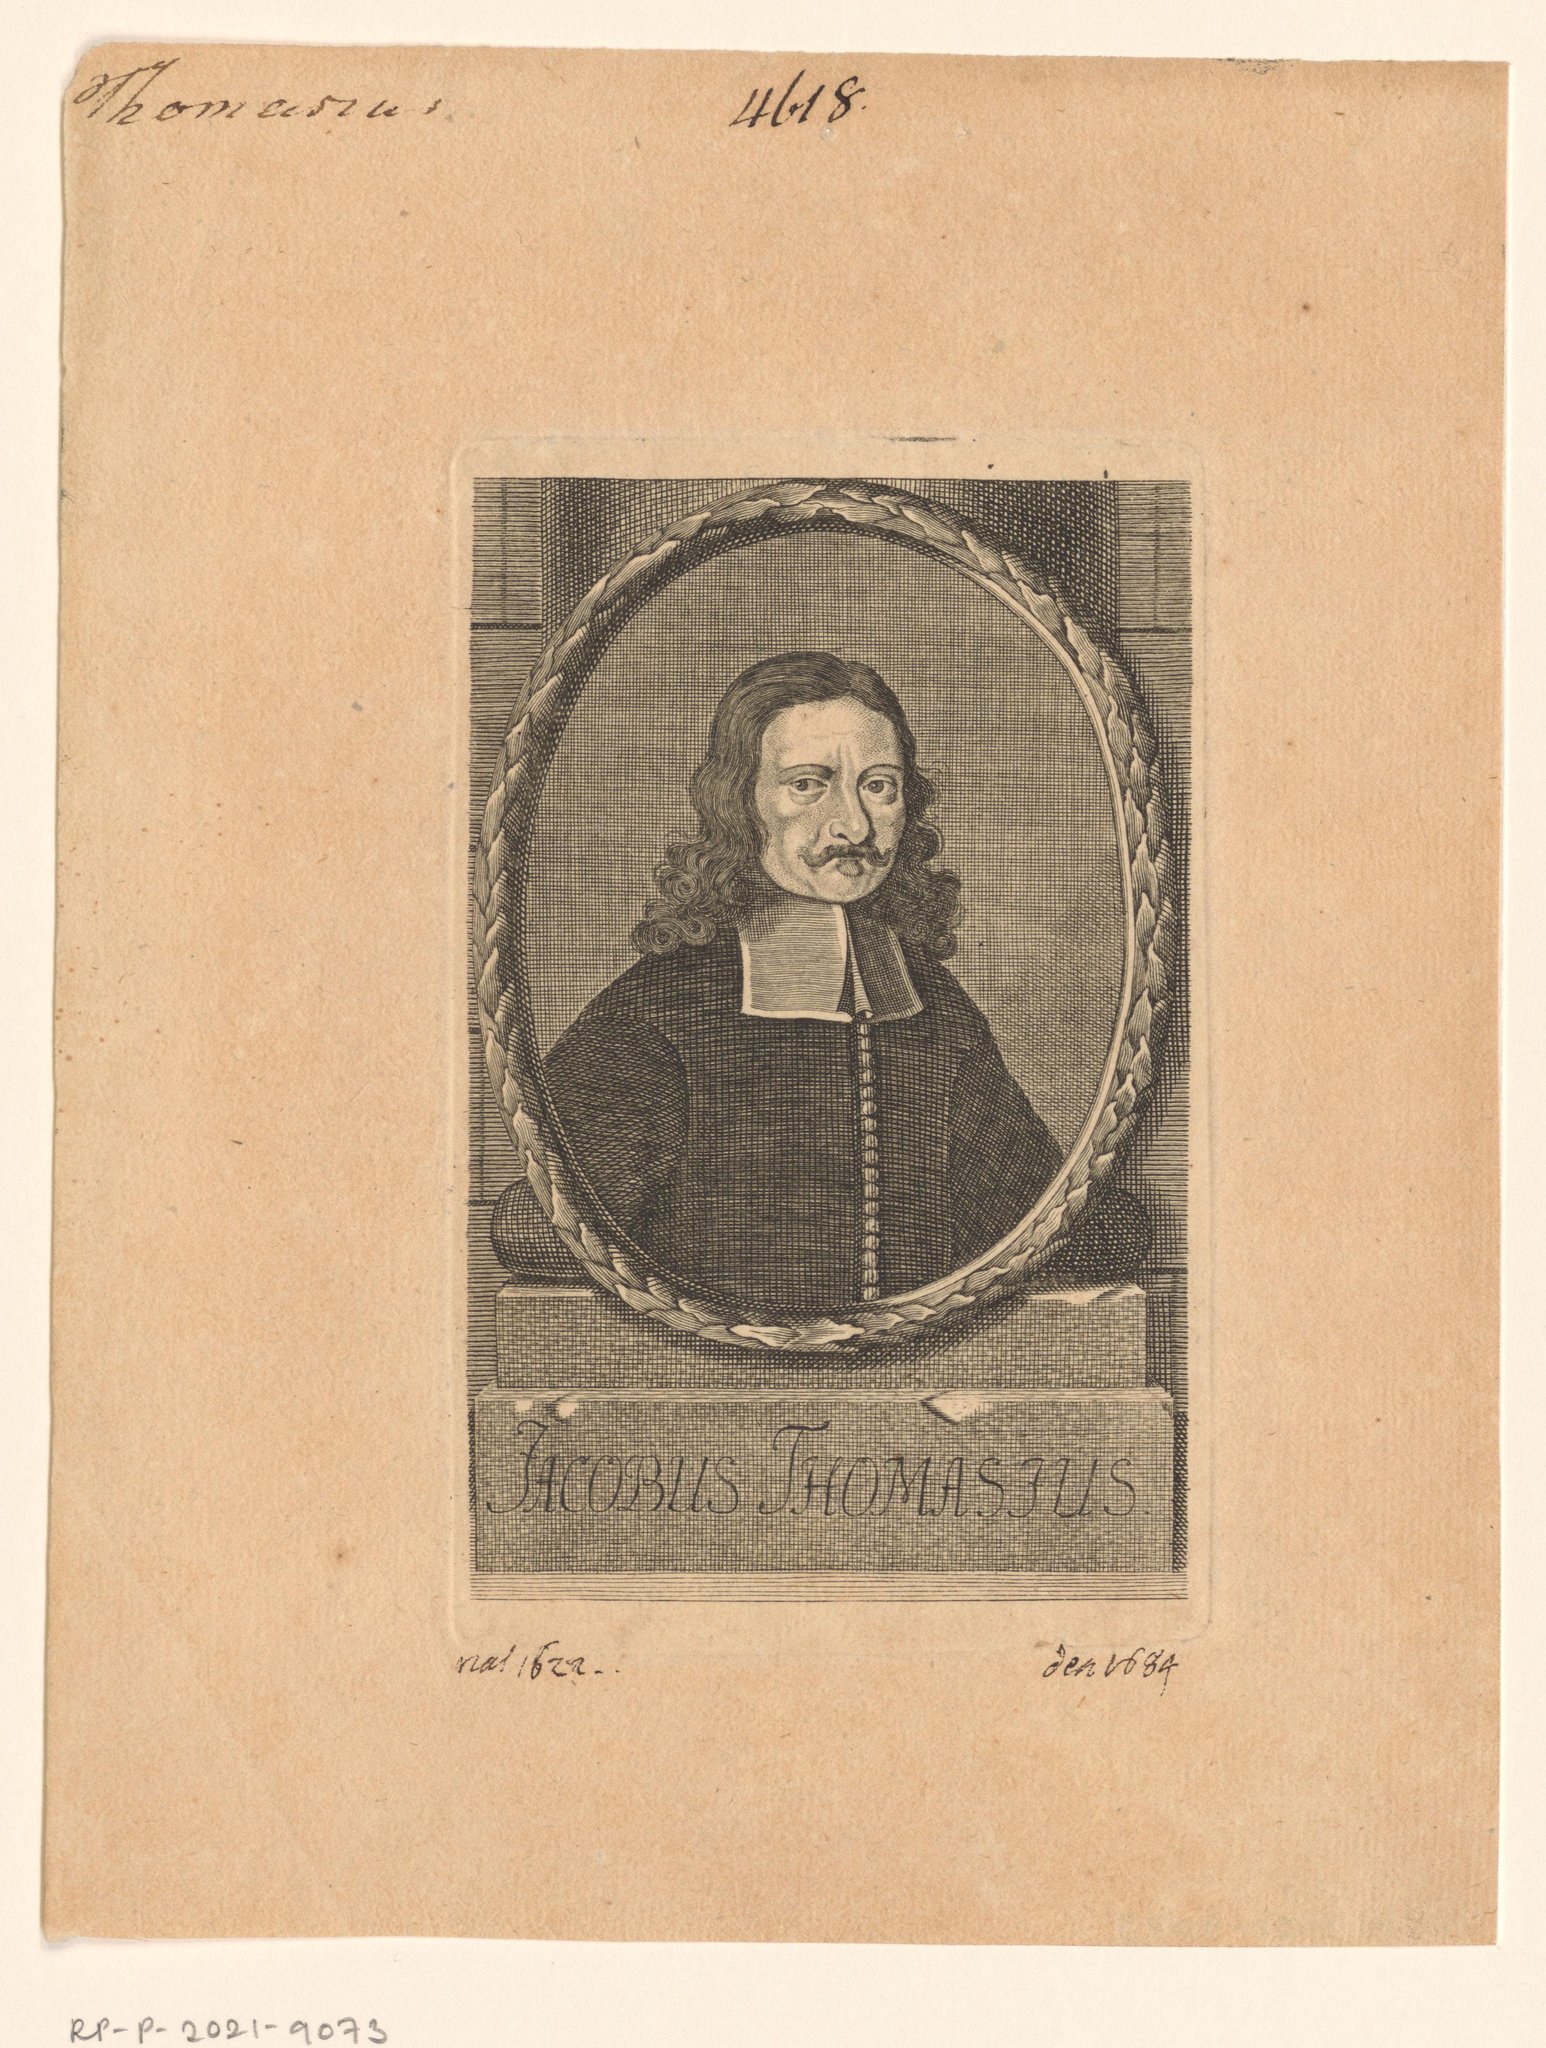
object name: print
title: Portret van Jacob Thomasius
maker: Anonymous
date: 1675-1749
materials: paper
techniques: engraving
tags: jacob thomasius, scholar, philosopher, historical persons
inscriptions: inscription: ‘nat 1622. den 1684’, inscription: ‘Thomasius 4618’